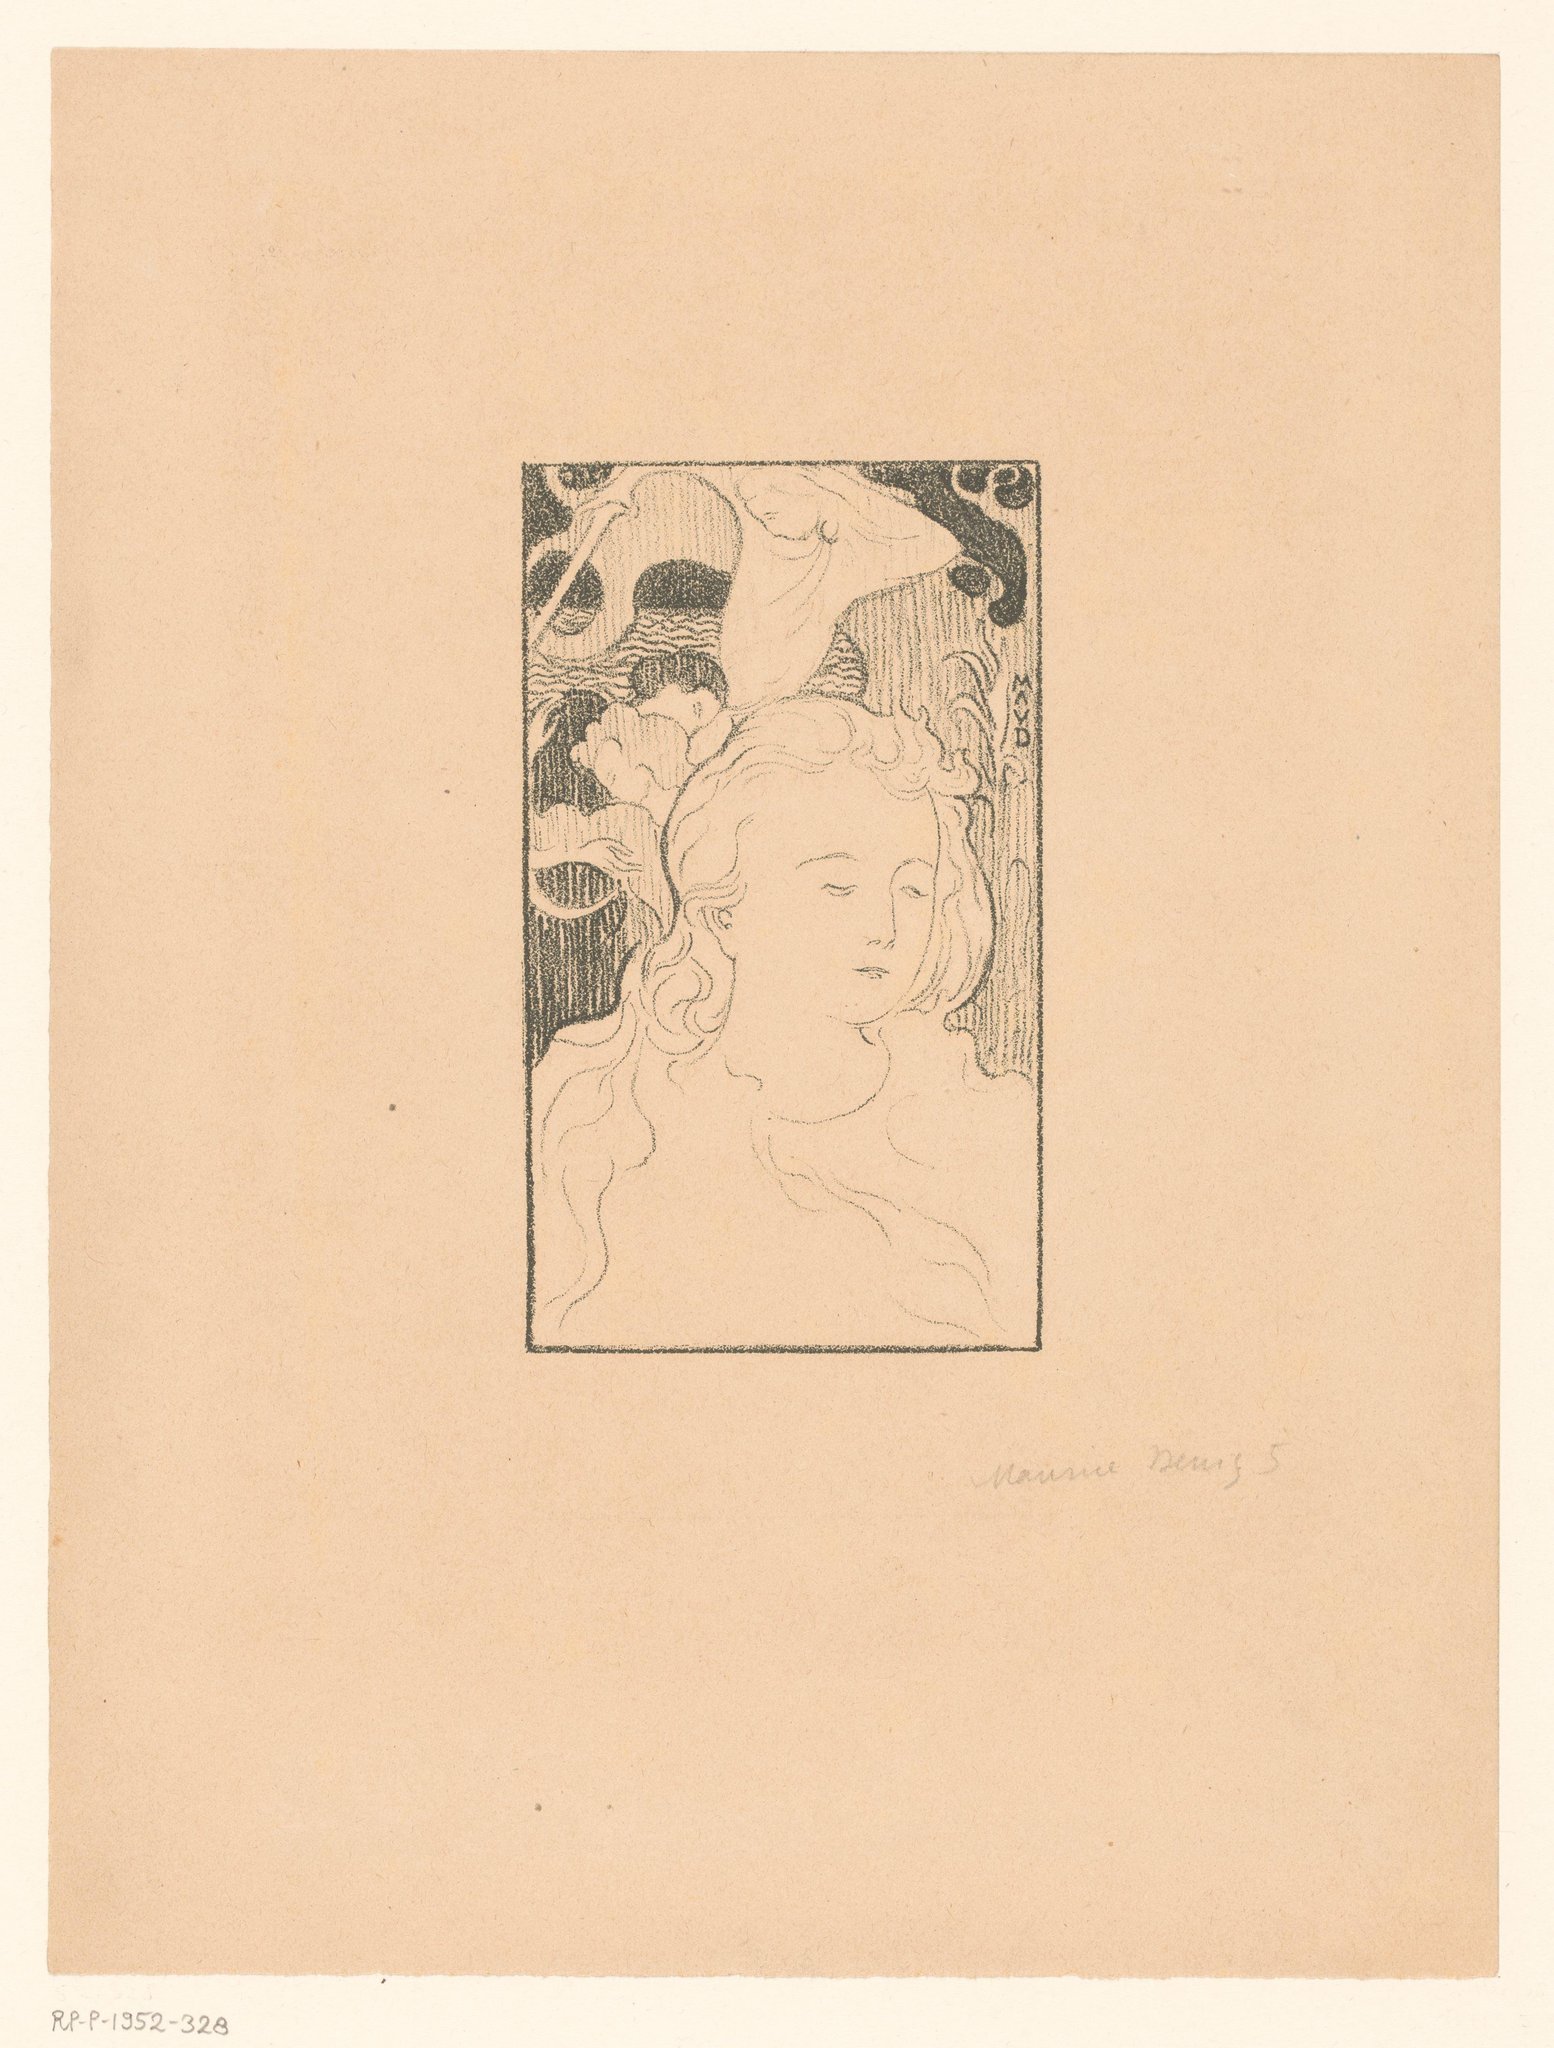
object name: print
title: Programme pour Pelléas et Mélisande, de Maurice Maeterlinck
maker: maurice denis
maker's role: print maker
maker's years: 1870-1943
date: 1893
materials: paper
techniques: lithograph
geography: paris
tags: adolescent, young woman, maiden, tragedy, poster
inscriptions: collector's mark: Lugt 2228a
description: Prent gebruikt als affiche voor Pelléas et Mélisande, een toneelstuk van de Belgische toneelschrijver Maurice Maeterlinck, opgevoerd in het Théâtre des Bouffes-Parisiens op 17 mei 1893.